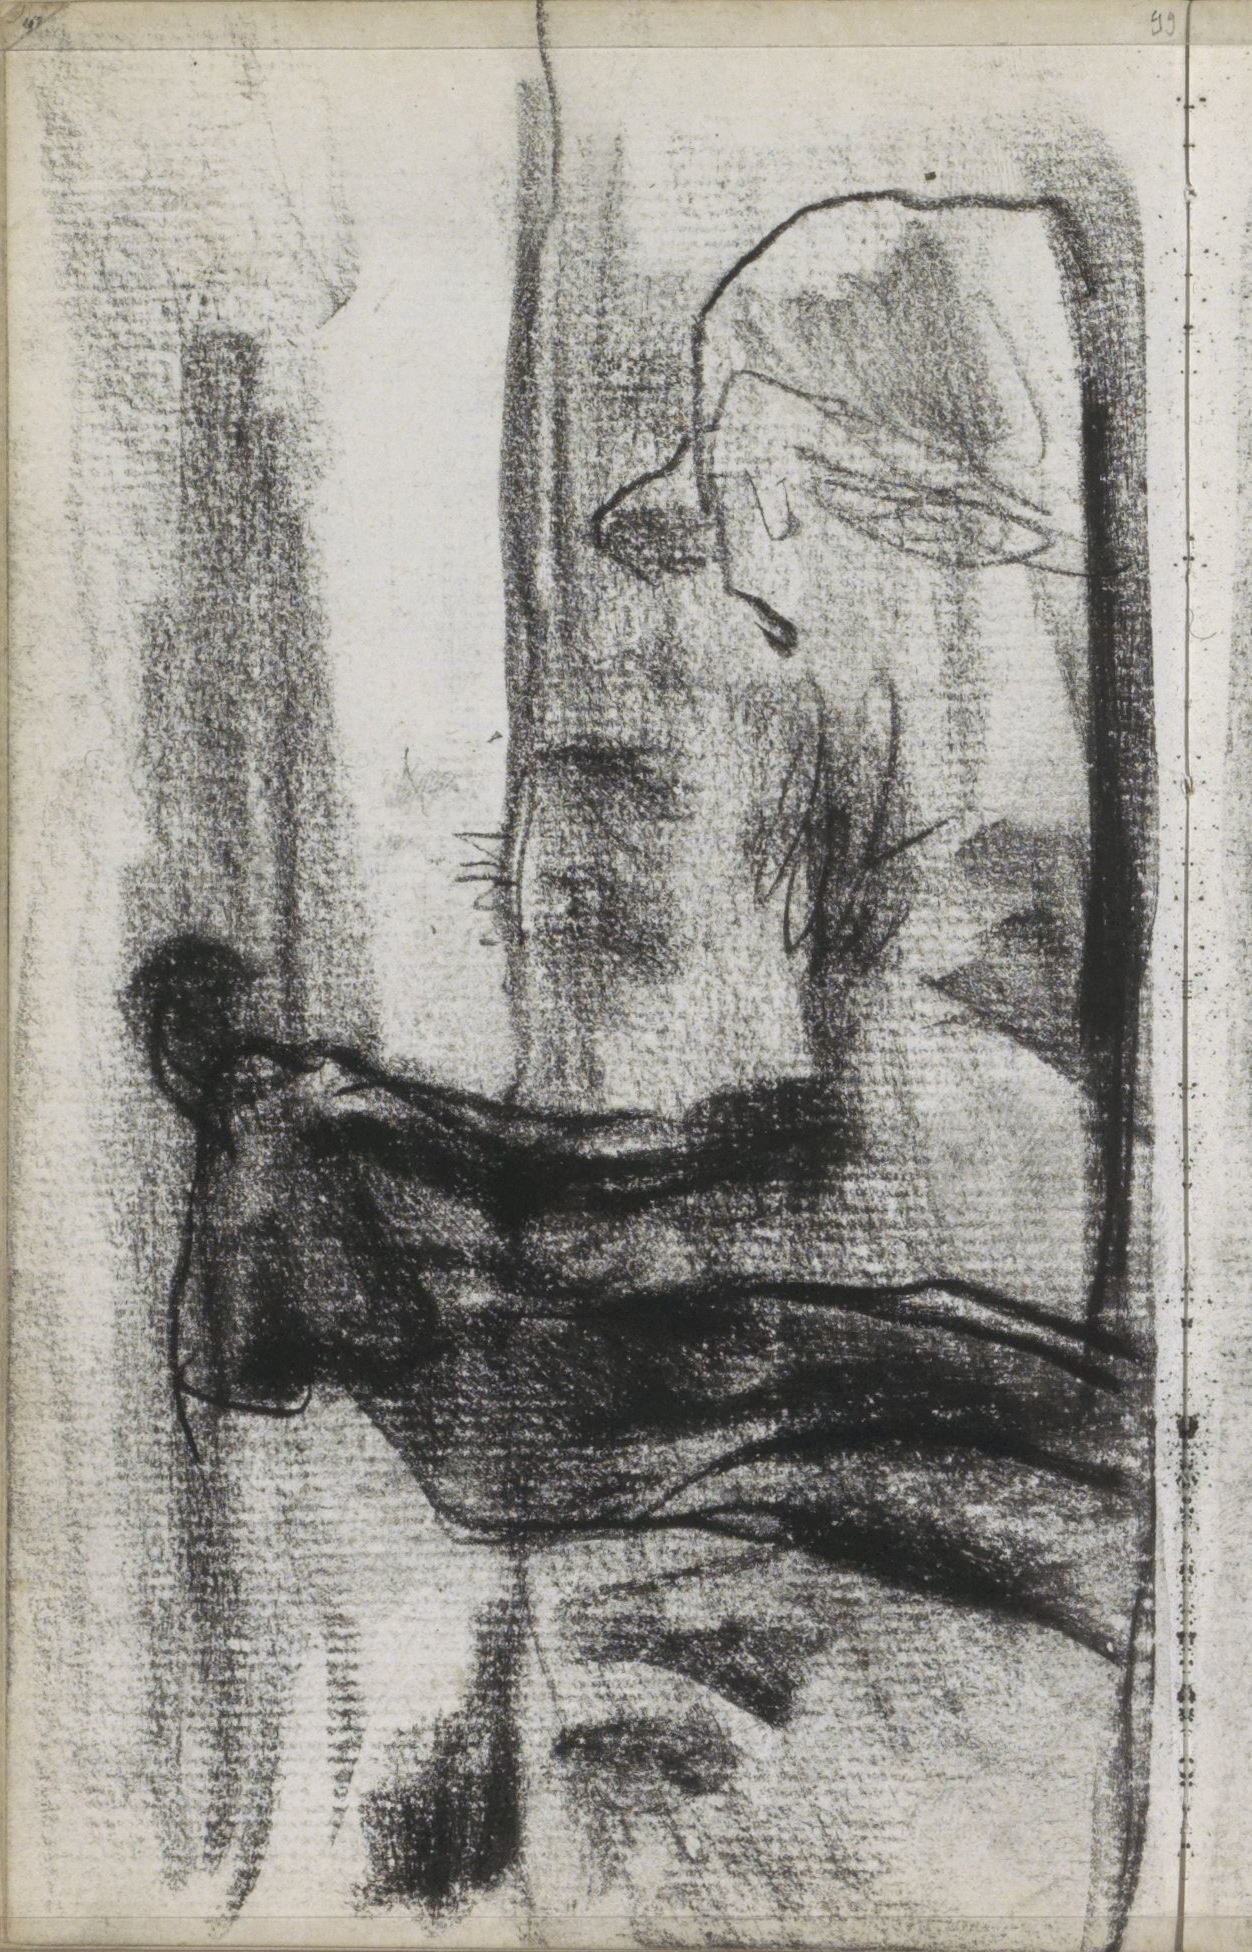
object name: sketchbook leaf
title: Boer op het land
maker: george hendrik breitner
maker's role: draughtsman, painter, print maker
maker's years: 1857-1923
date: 1884-1886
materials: chalk, paper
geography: drenthe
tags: farmers, cultivated land, horse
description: Naast hem mogelijk een paard. Pagina 99 uit een schetsboek met 67 bladen vervaardigd in Drenthe.